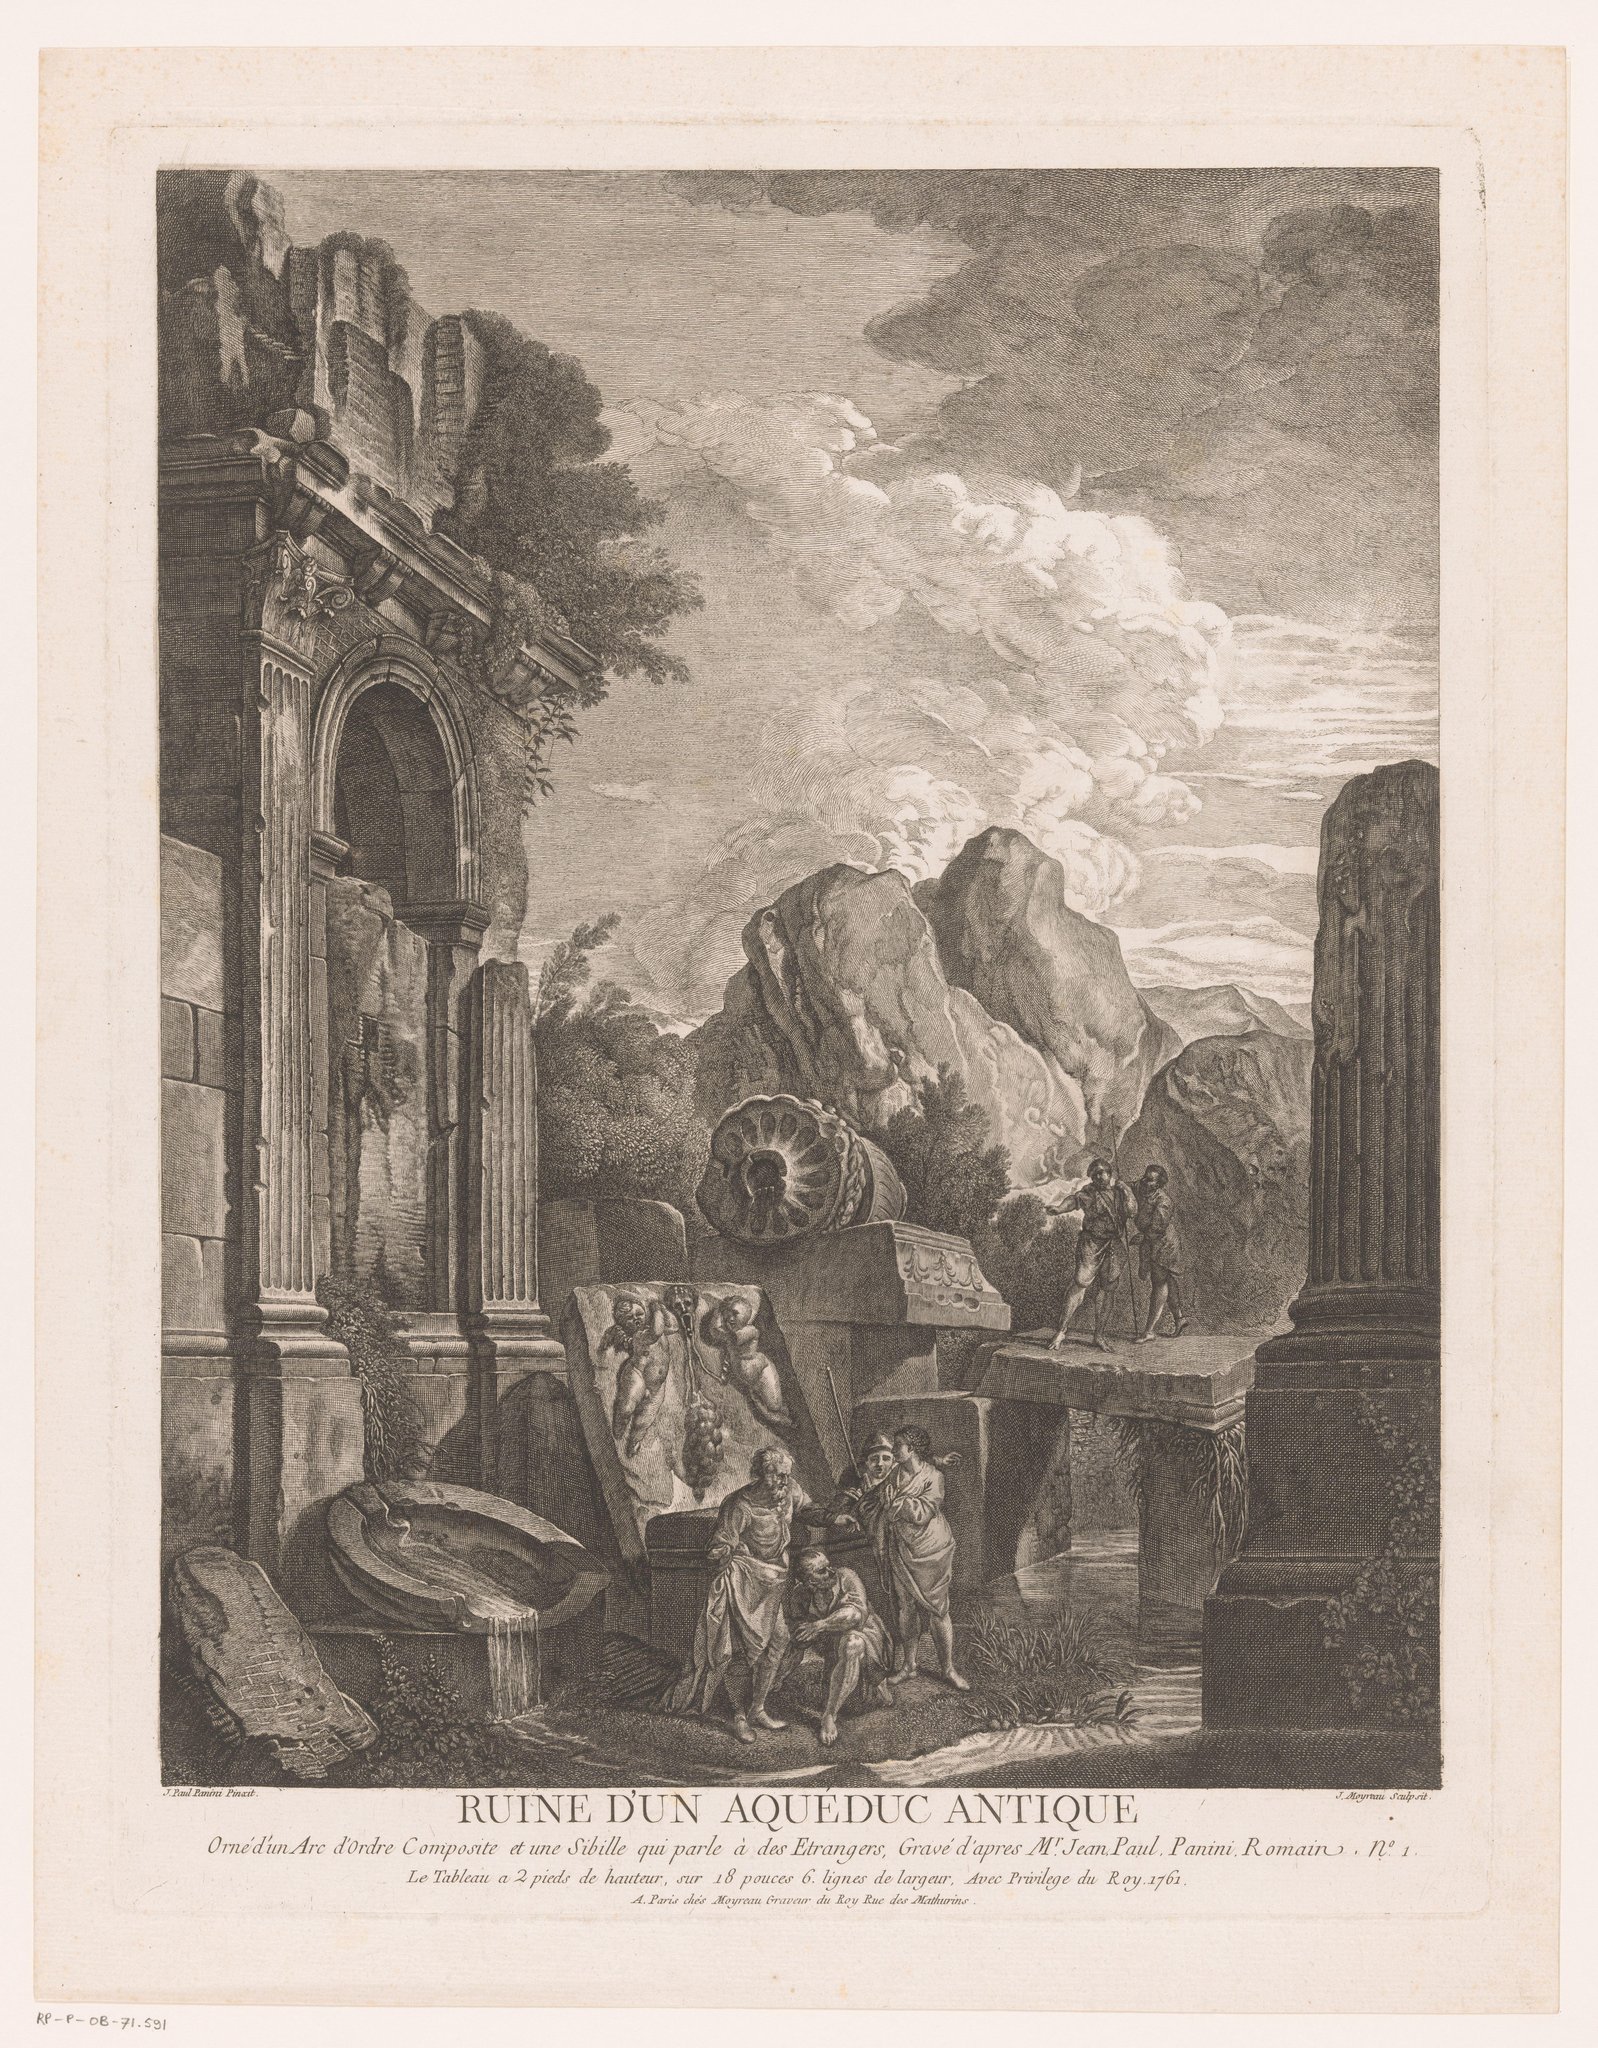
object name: print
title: Ruïne d'un Aqueduc antique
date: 1701-1762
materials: paper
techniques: engraving, etching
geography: paris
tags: landscape with ruins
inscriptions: collector's mark: Lugt 2228